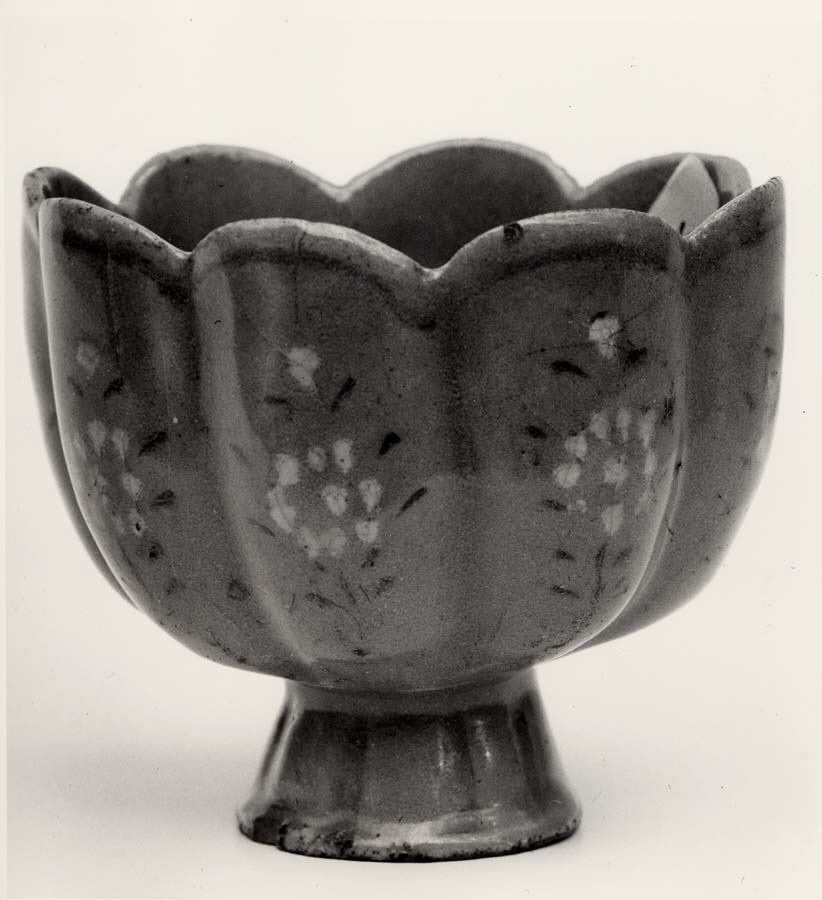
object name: cup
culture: korean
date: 1201-1300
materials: porcelain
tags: flowers